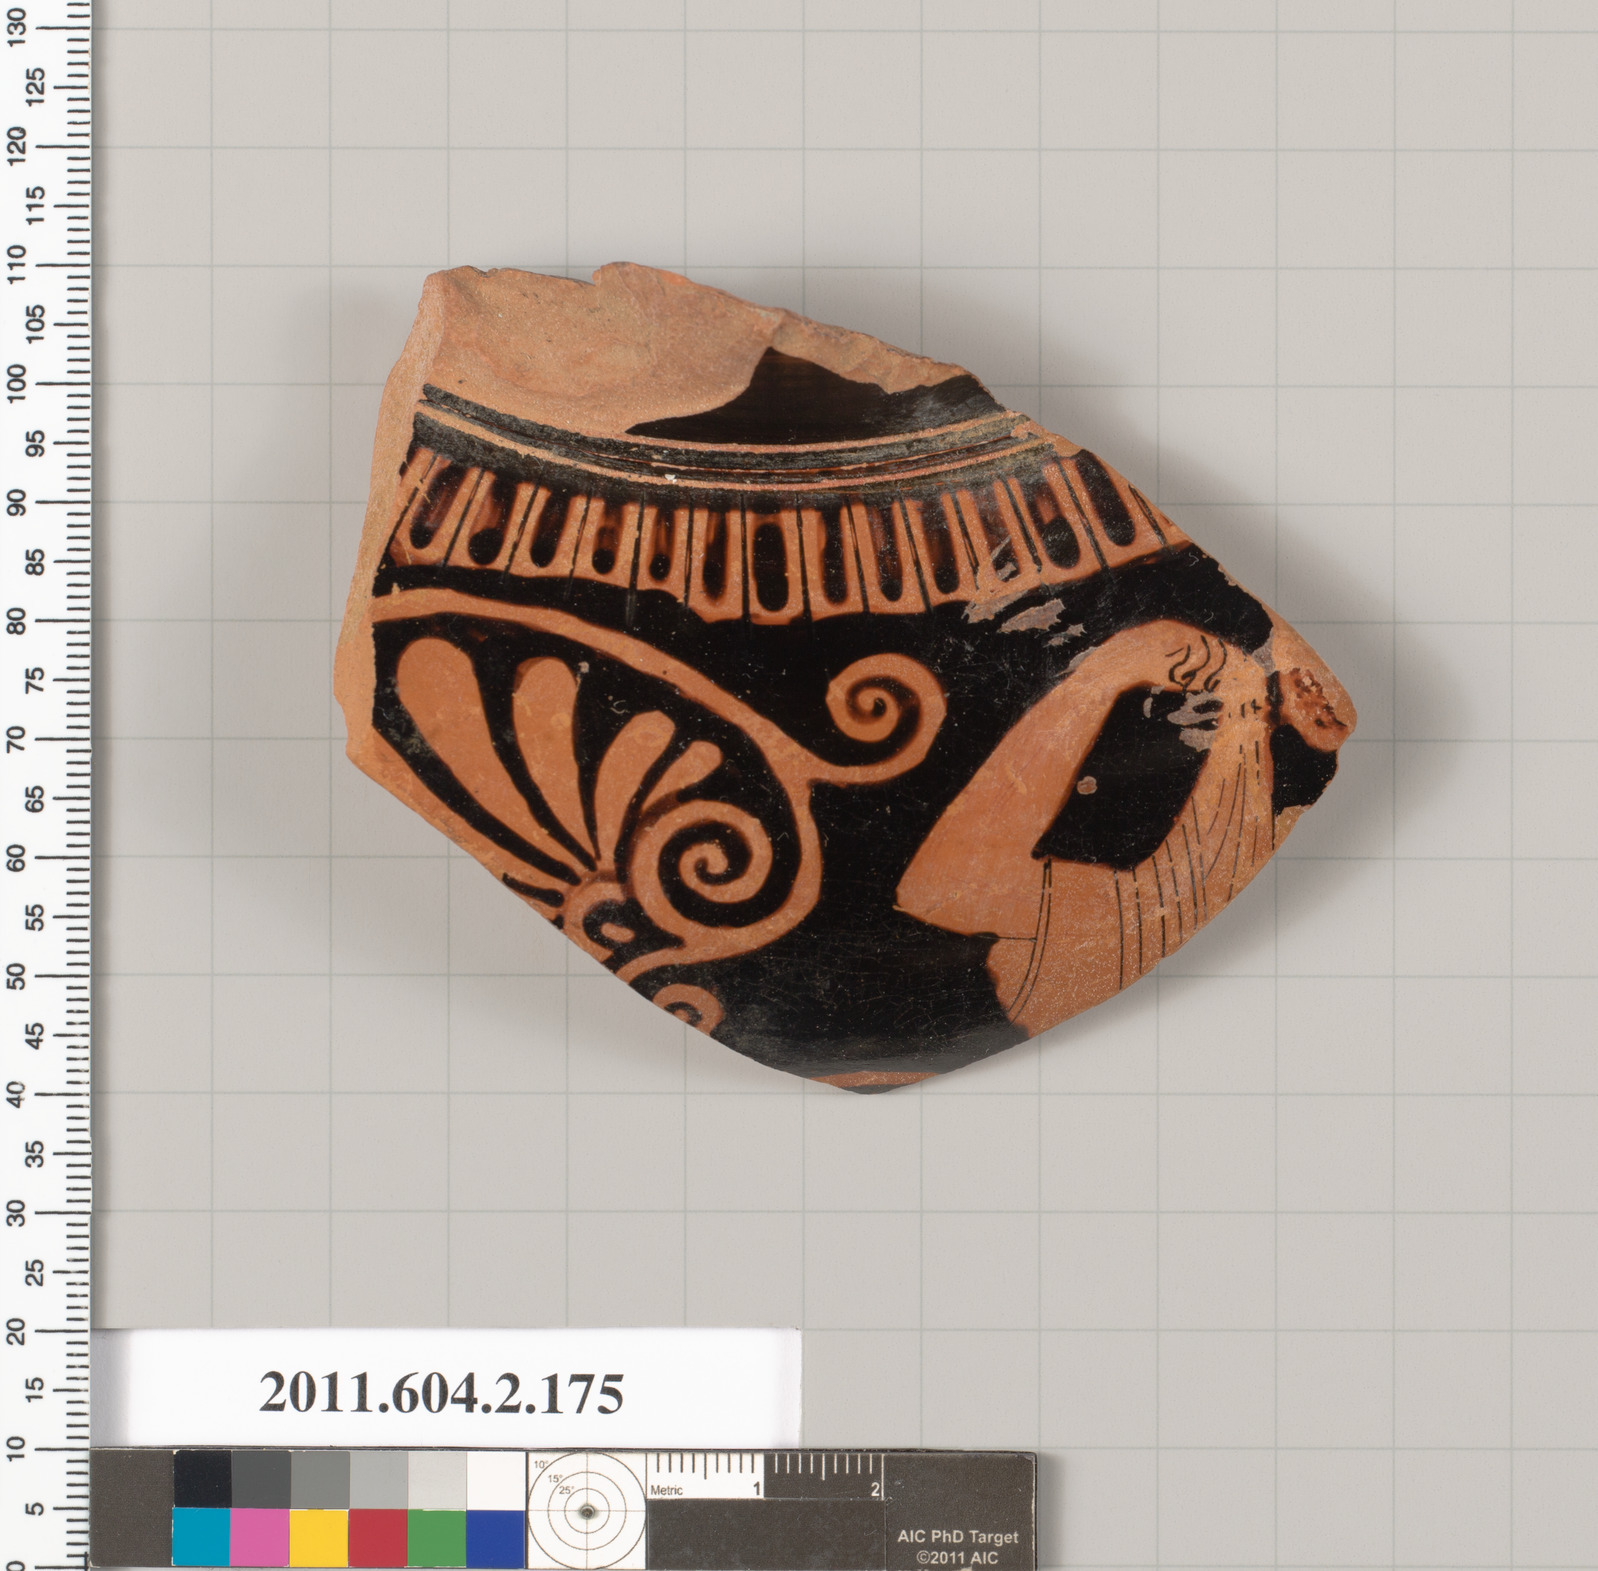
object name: stamnos fragment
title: Terracotta fragment of a stamnos (jar)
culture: greek, attic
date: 450-426 BCE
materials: terracotta